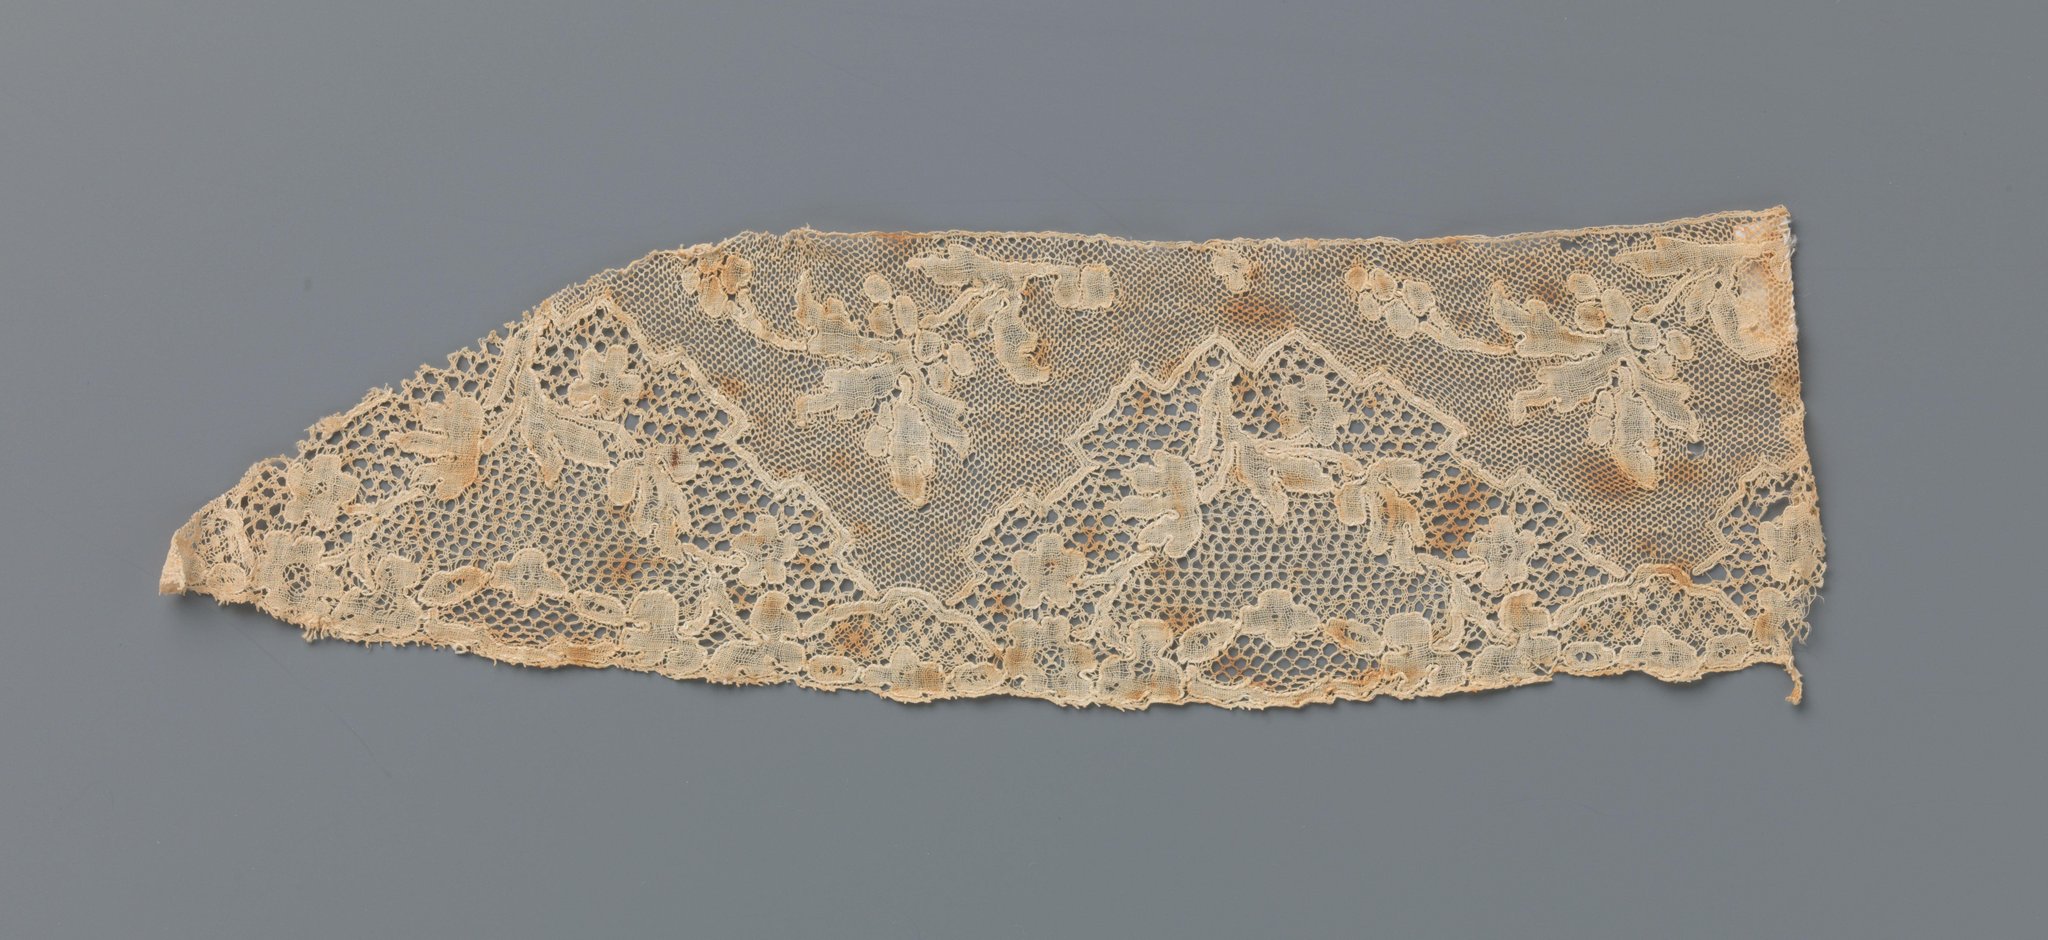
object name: strip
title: Strook kloskant met driehoekig veld met zich splitsende tak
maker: Anonymous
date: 1700-1724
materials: linen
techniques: lace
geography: mechelen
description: Strook naturelkleurige kloskant: Mechelse kant. Het zich herhalende patroon bestaat uit een driehoekig veld, met als basis de onderzijde van de strook en een top die iets onder de bovenzijde van de strook eindigt. De zijden van de driehoek worden gevormd door een lijn met knikken erin. Vanuit de top hangt een zich splitsende tak naar beneden, met grillige bladeren en rozetbloemen. Het patroon langs de onderzijde wordt gevormd door de bloemen en bladeren aan het eind van deze takken en door min of meer ovale cartouches. Tussen de opeenvolgende driehoekige velden is een losse bloem met steel en blad te zien, die iets schuin vanaf boven naar beneden gericht is. De motieven zijn met elkaar verbonden door een maasgrond, de Mechelse grond. De motieven zijn gemaakt in linnenslag met weinig uitsparingen en dikkere en glimmende contourdraden. In het driehoekige veld zijn twee verschillende siergronden toegepast en in de cartouches langs de onderzijde nog twee andere, waaronder een sneeuwvlokkengrond. De flauw geschulpt onderzijde is afgewerkt met picots. De bovenzijde is recht afgewerkt.